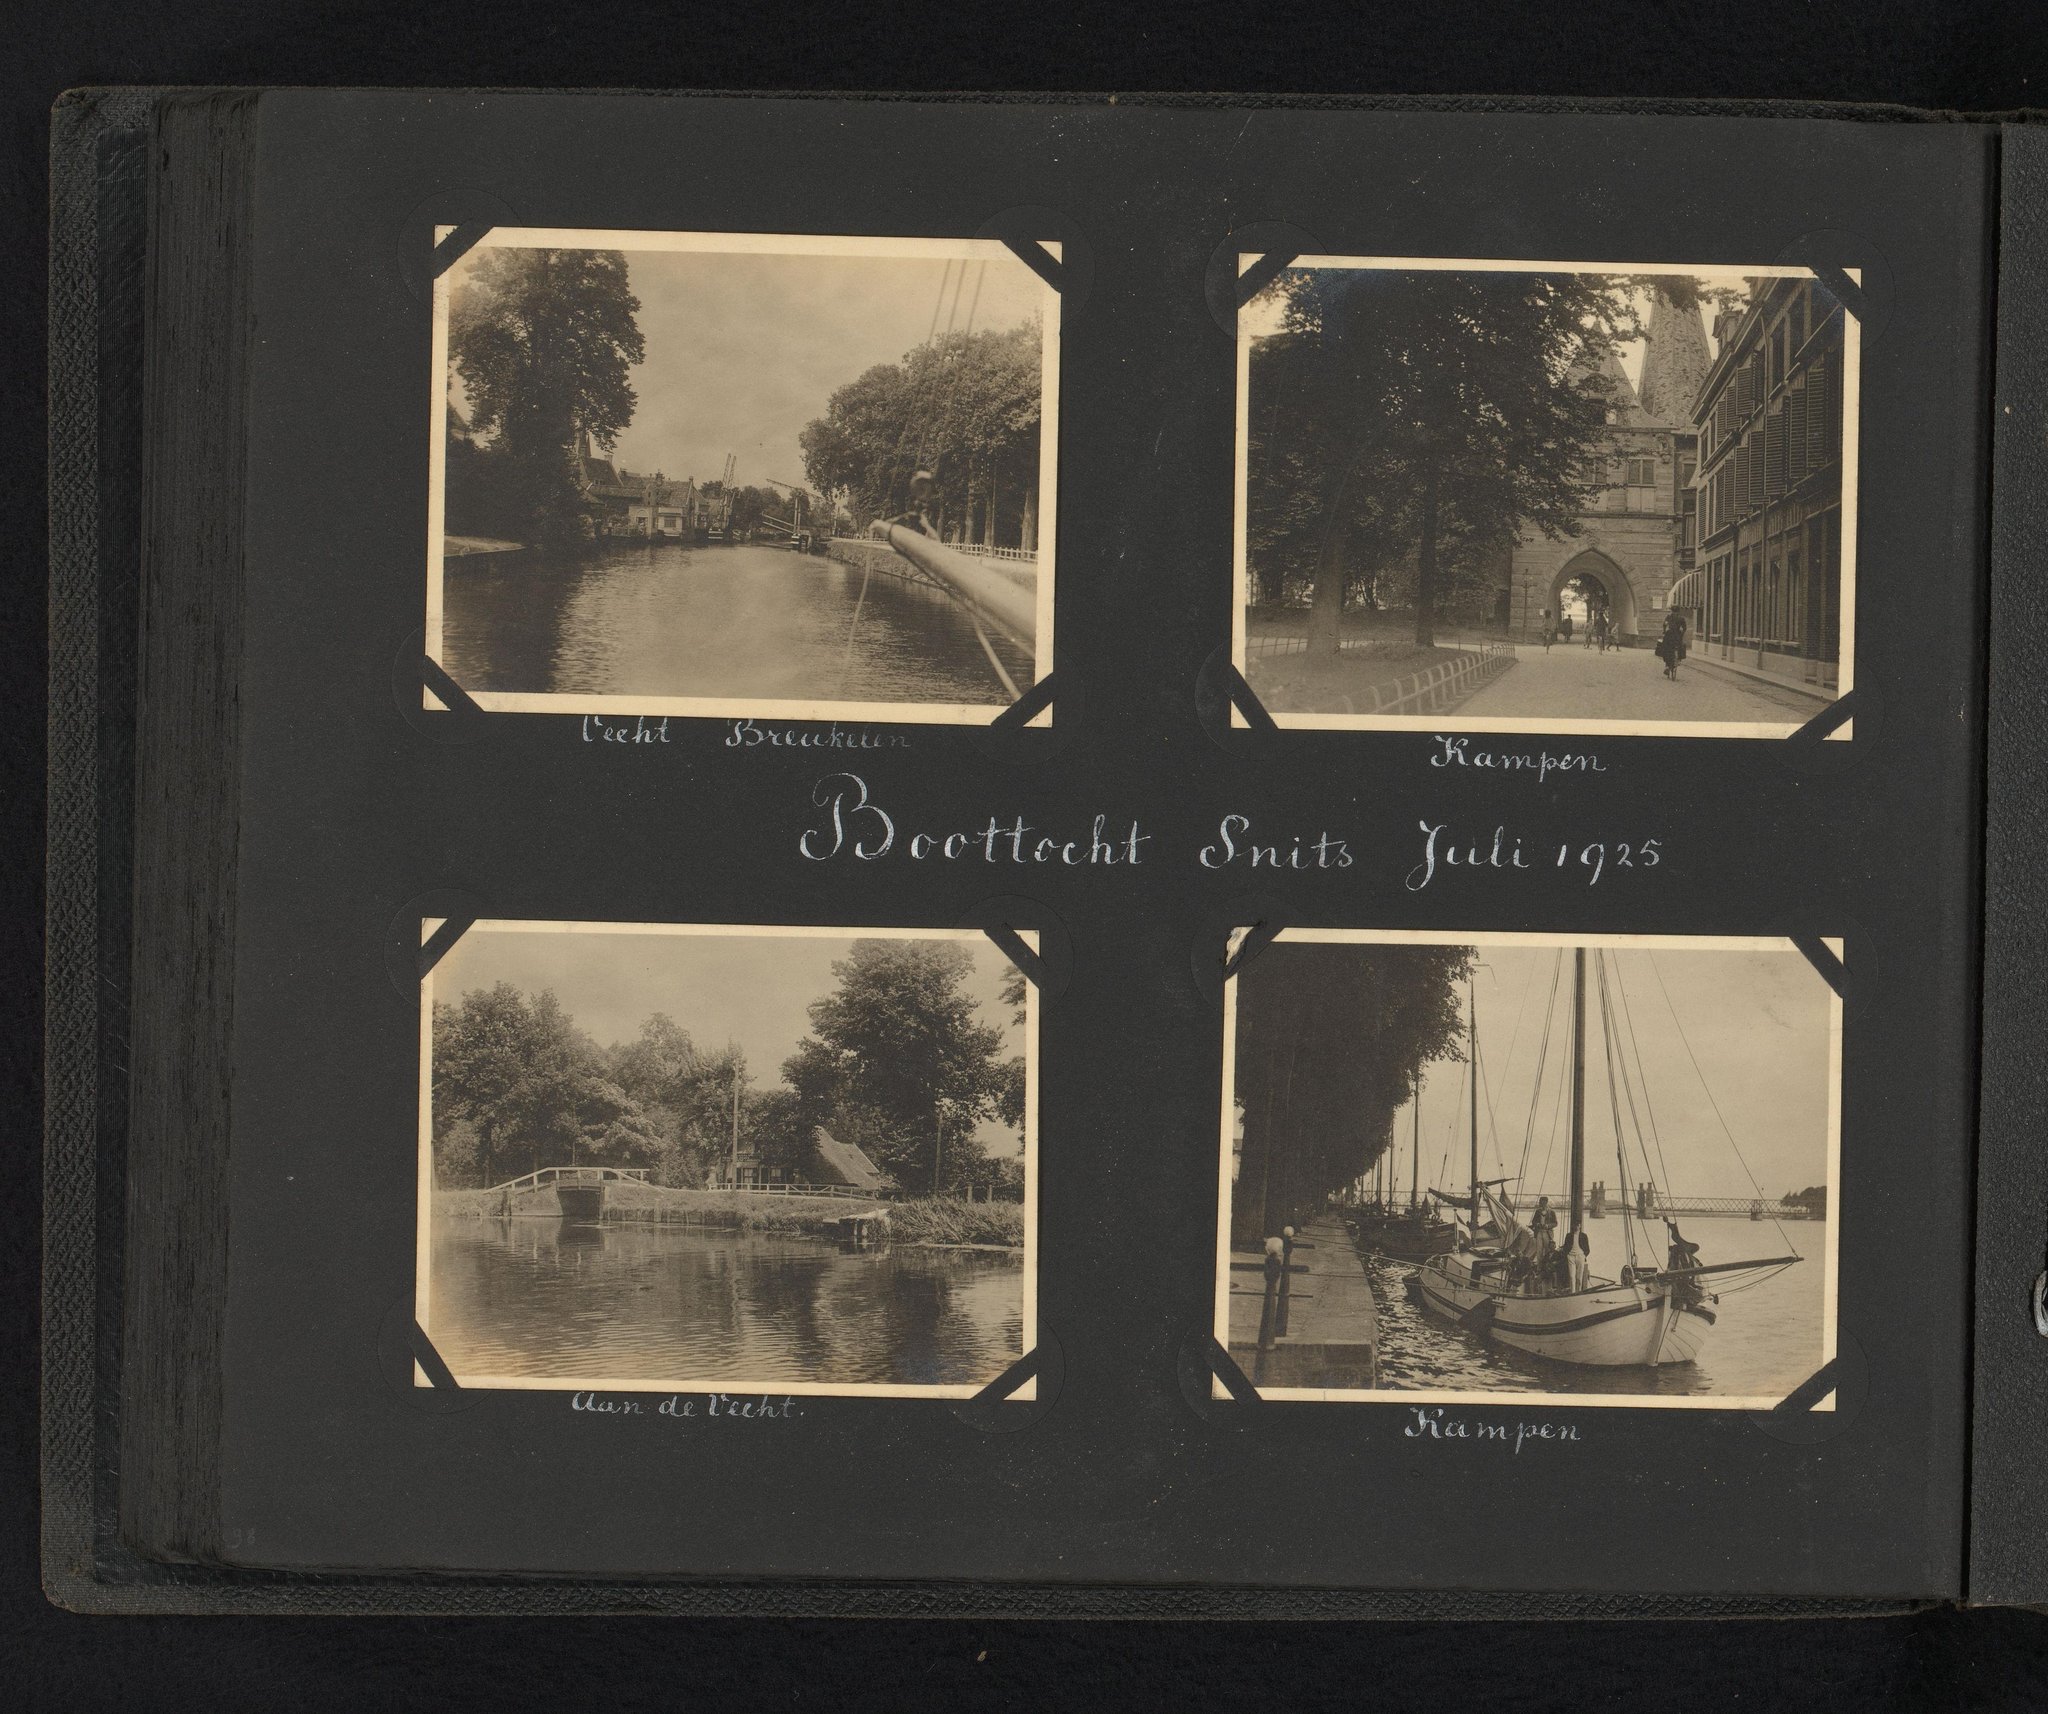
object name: album leaf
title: Boottocht Snits Juli 1925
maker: hendrik herman van den berg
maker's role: amateurfotograaf, jurist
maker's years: 1875-1944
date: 1907-1925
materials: paper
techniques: gelatin silver print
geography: netherlands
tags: sailing-ship, sailing-boat, river, vecht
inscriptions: inscription: ‘Kampen’, inscription: ‘Kampen’, inscription: ‘Vecht Breukelen’, inscription: ‘Aan de Vecht.’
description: Deze foto's maken deel uit van een album.